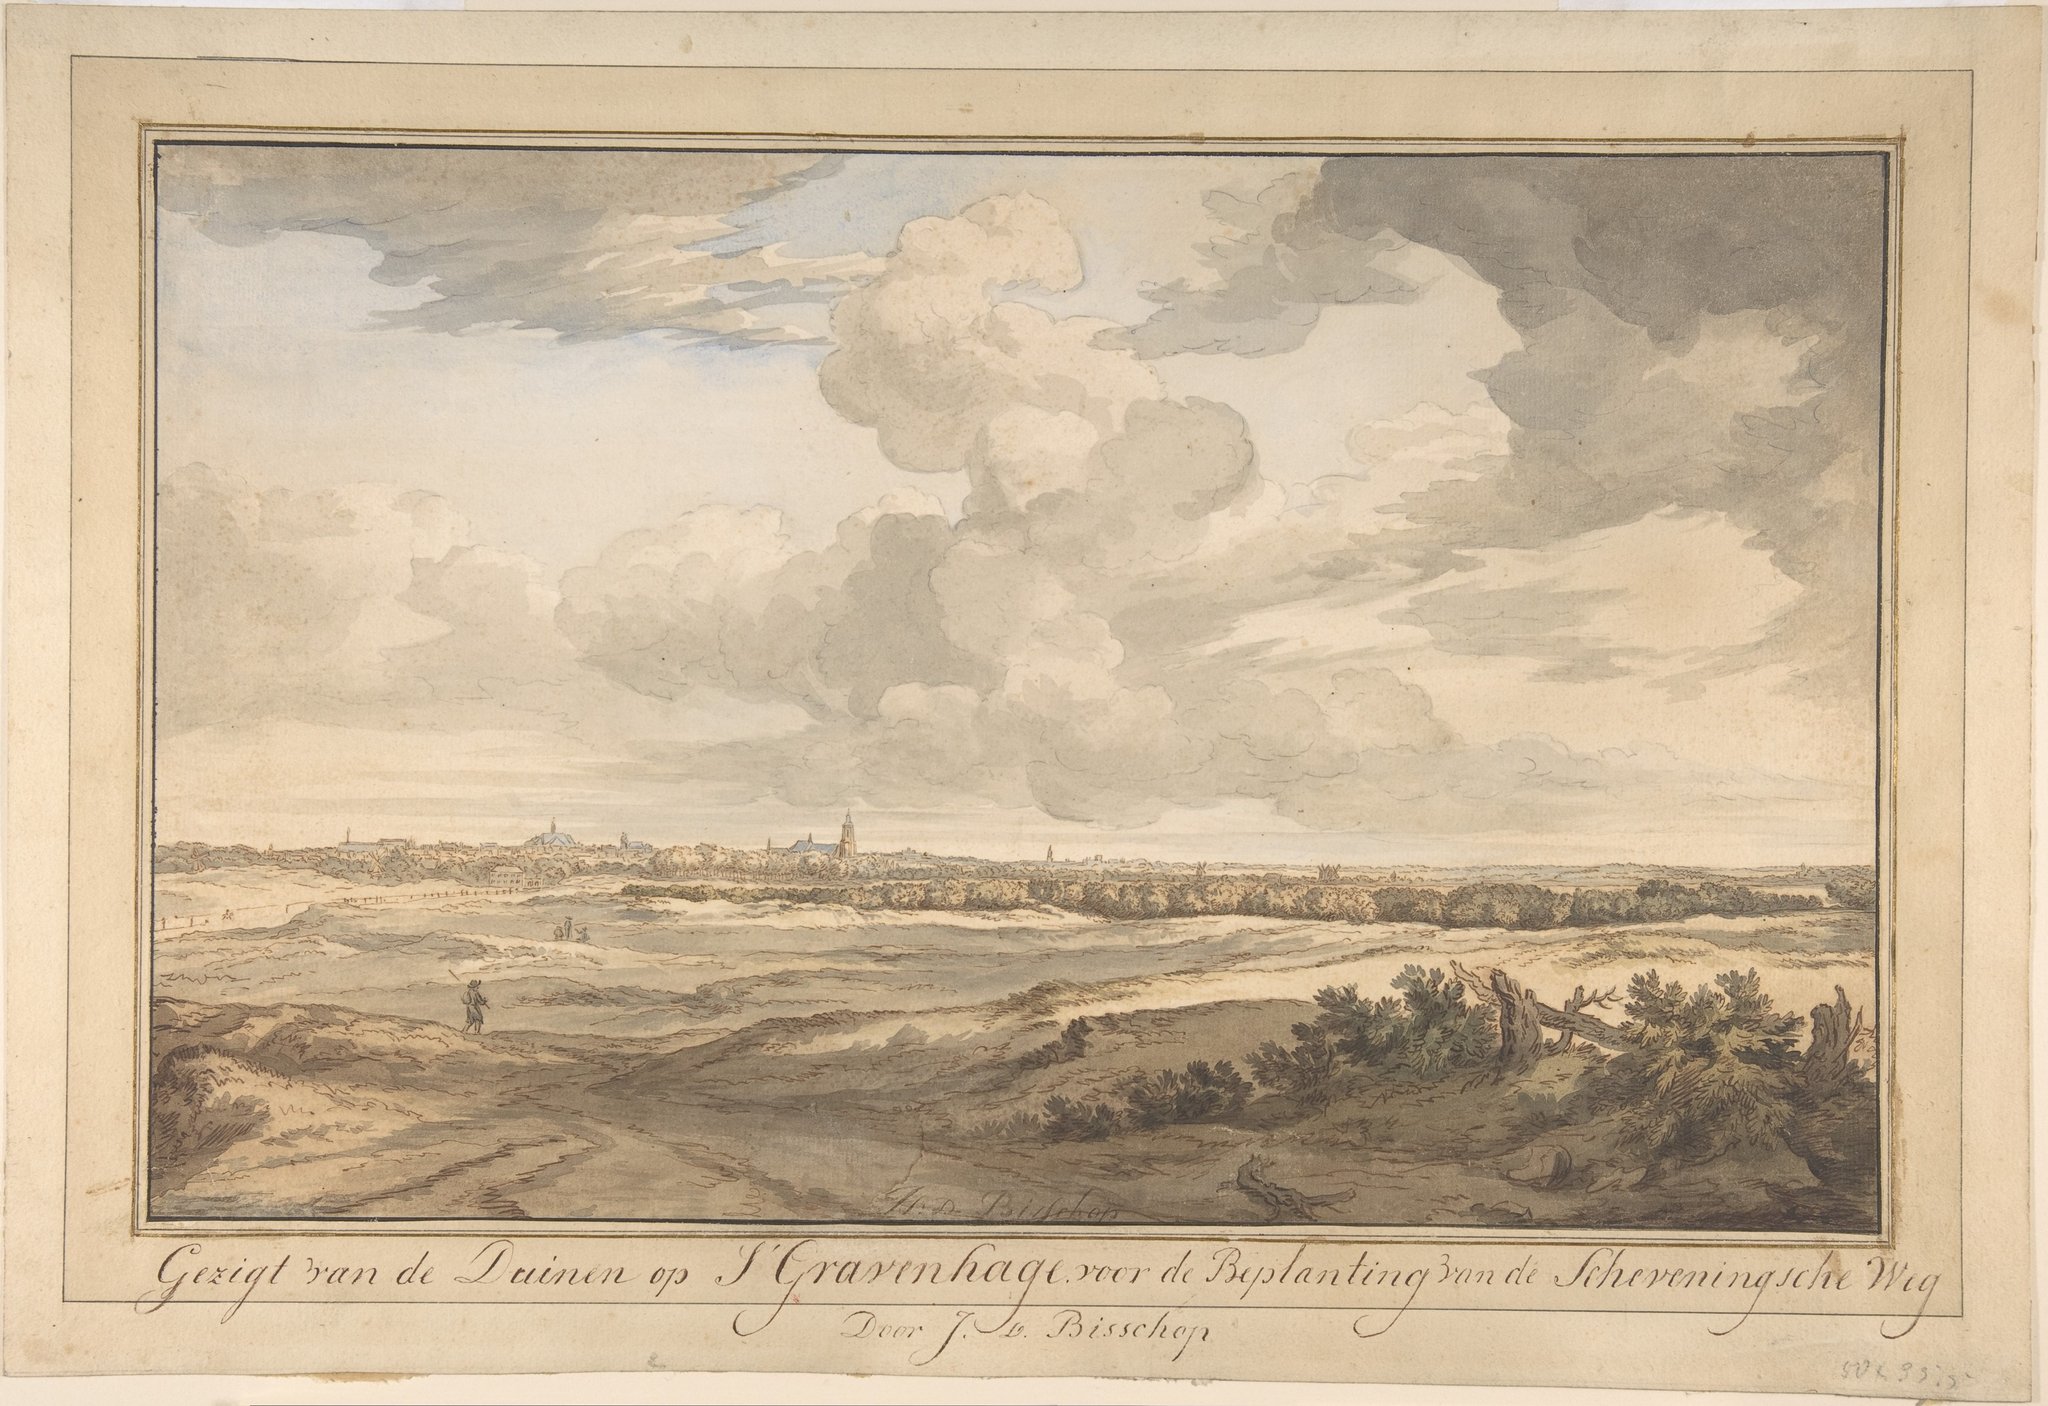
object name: drawing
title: Panoramic Landscapes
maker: anonymous, dutch, 18th century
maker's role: artist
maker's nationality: dutch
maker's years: 1700-1800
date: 1701-1800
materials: chalk, ink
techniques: brush, pen, wash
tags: landscapes